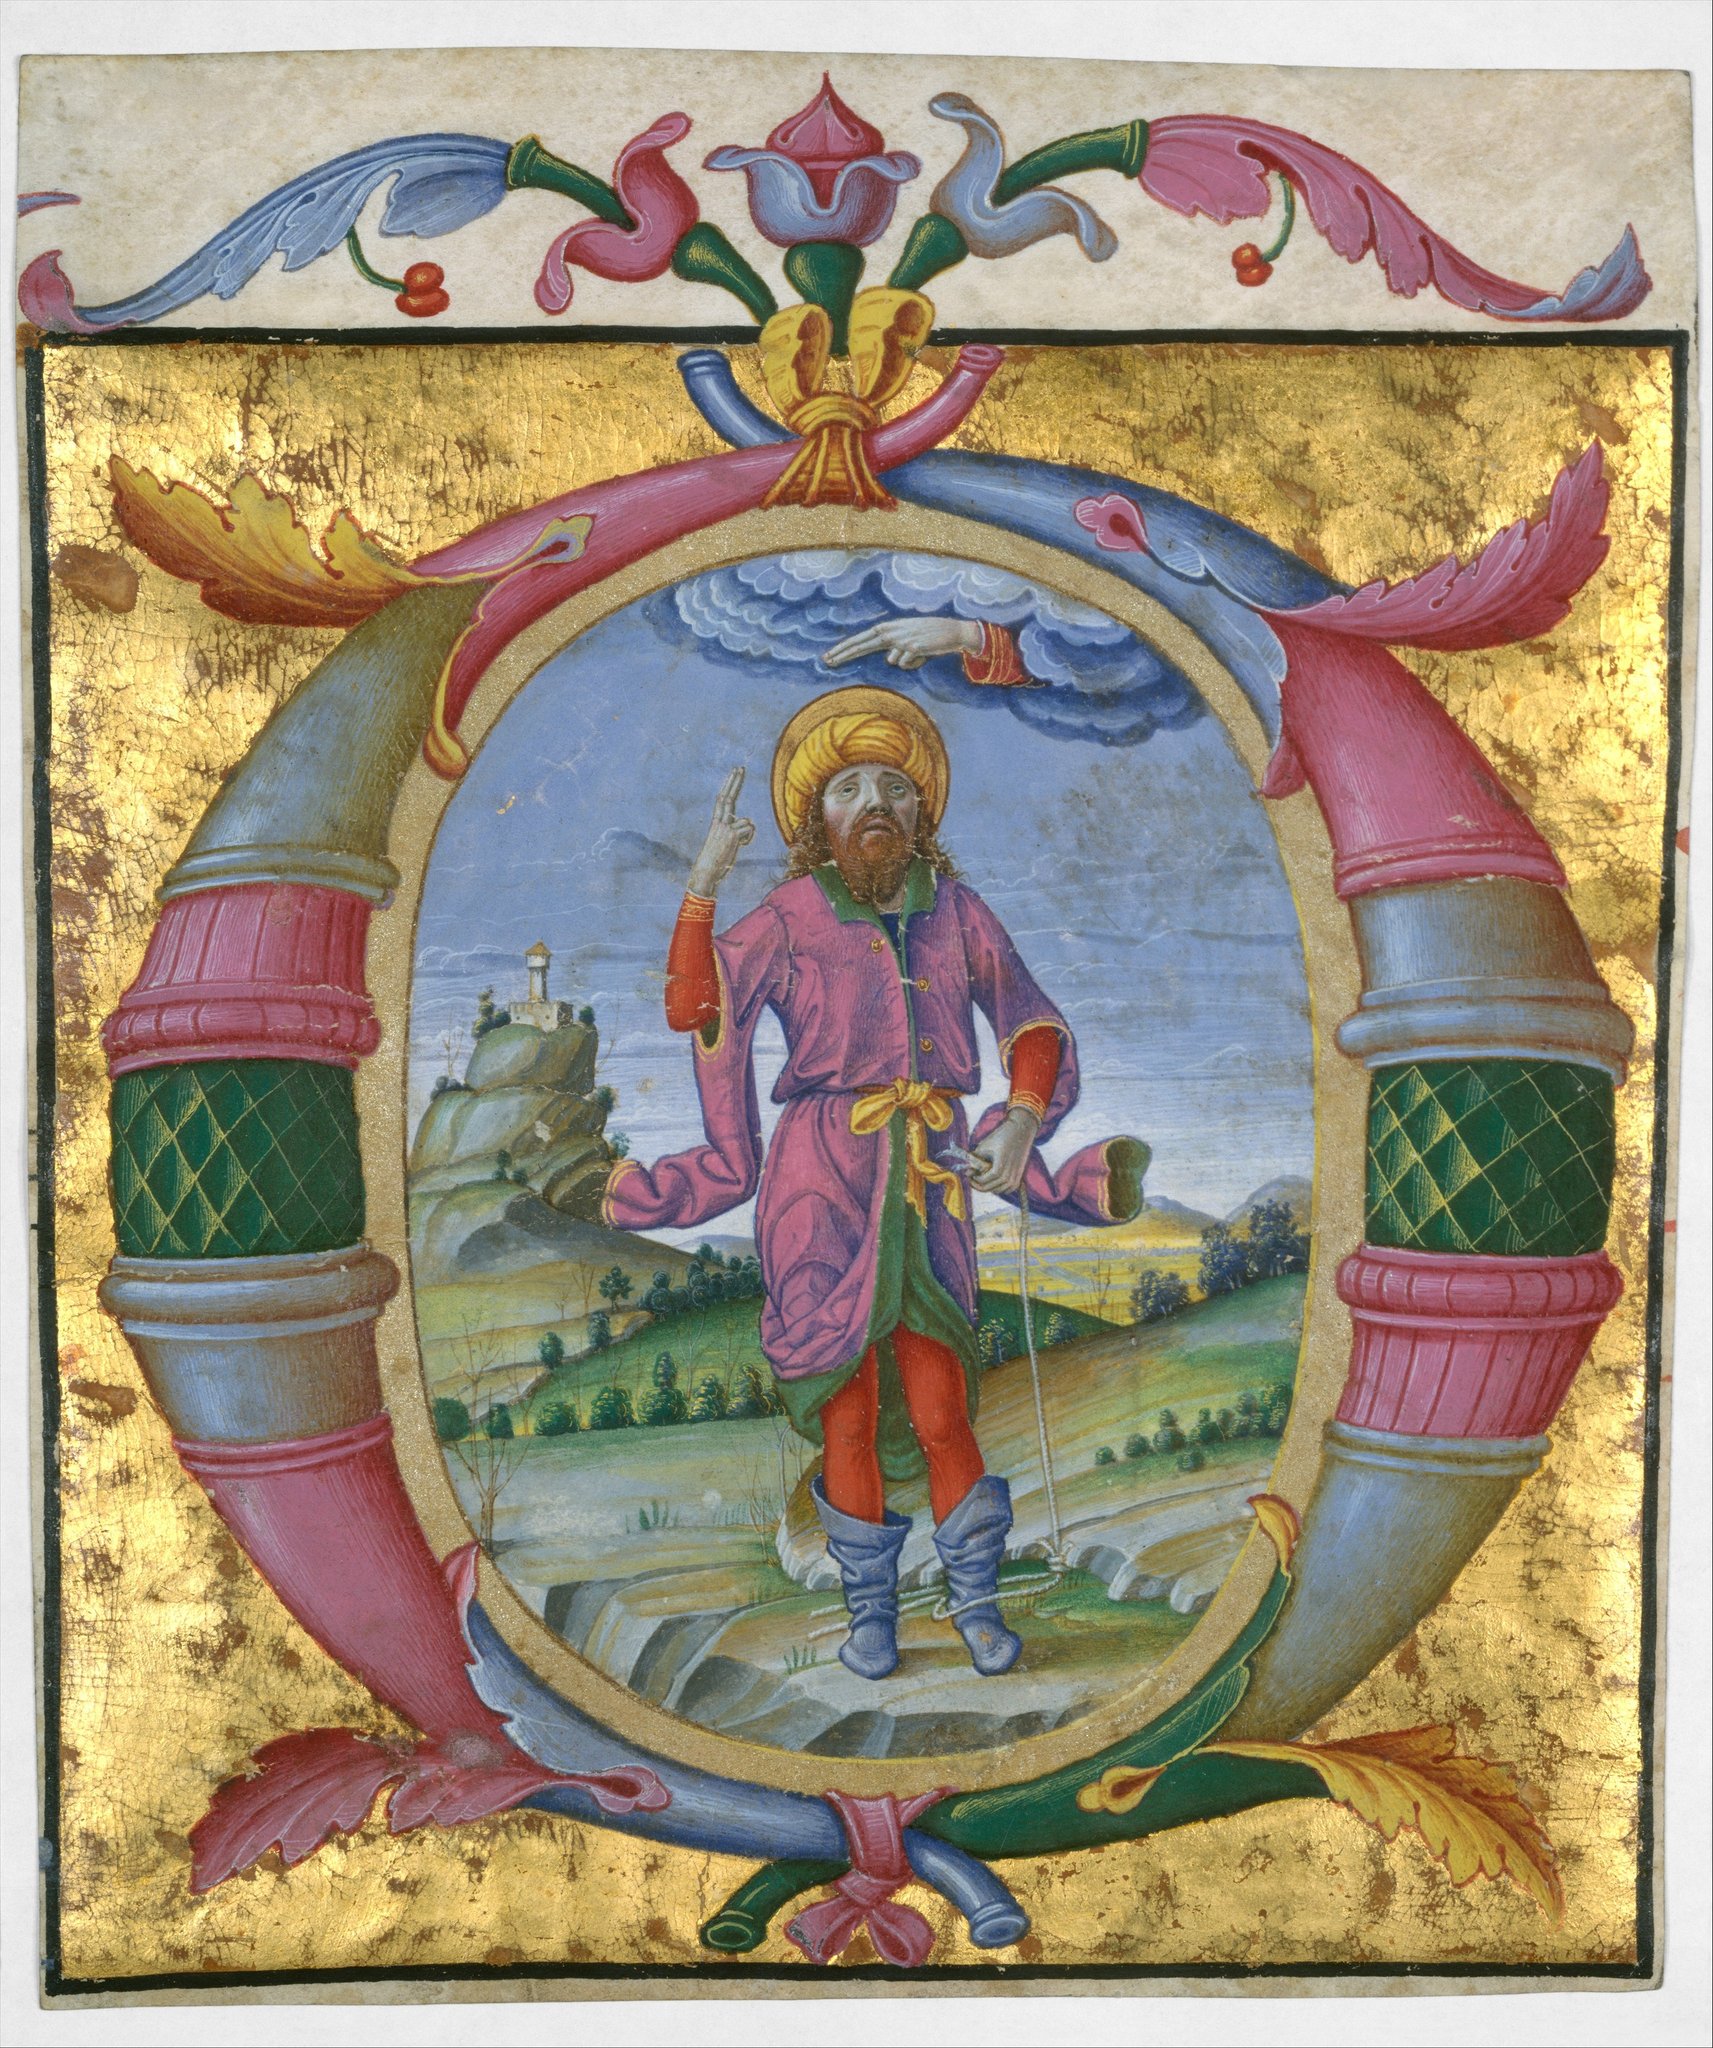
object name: cutting from a gradual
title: David with His Foot in a Noose in an Initial O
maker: domenico morone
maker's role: artist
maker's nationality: italian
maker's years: 1437-1523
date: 1500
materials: gold, parchment, paint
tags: men